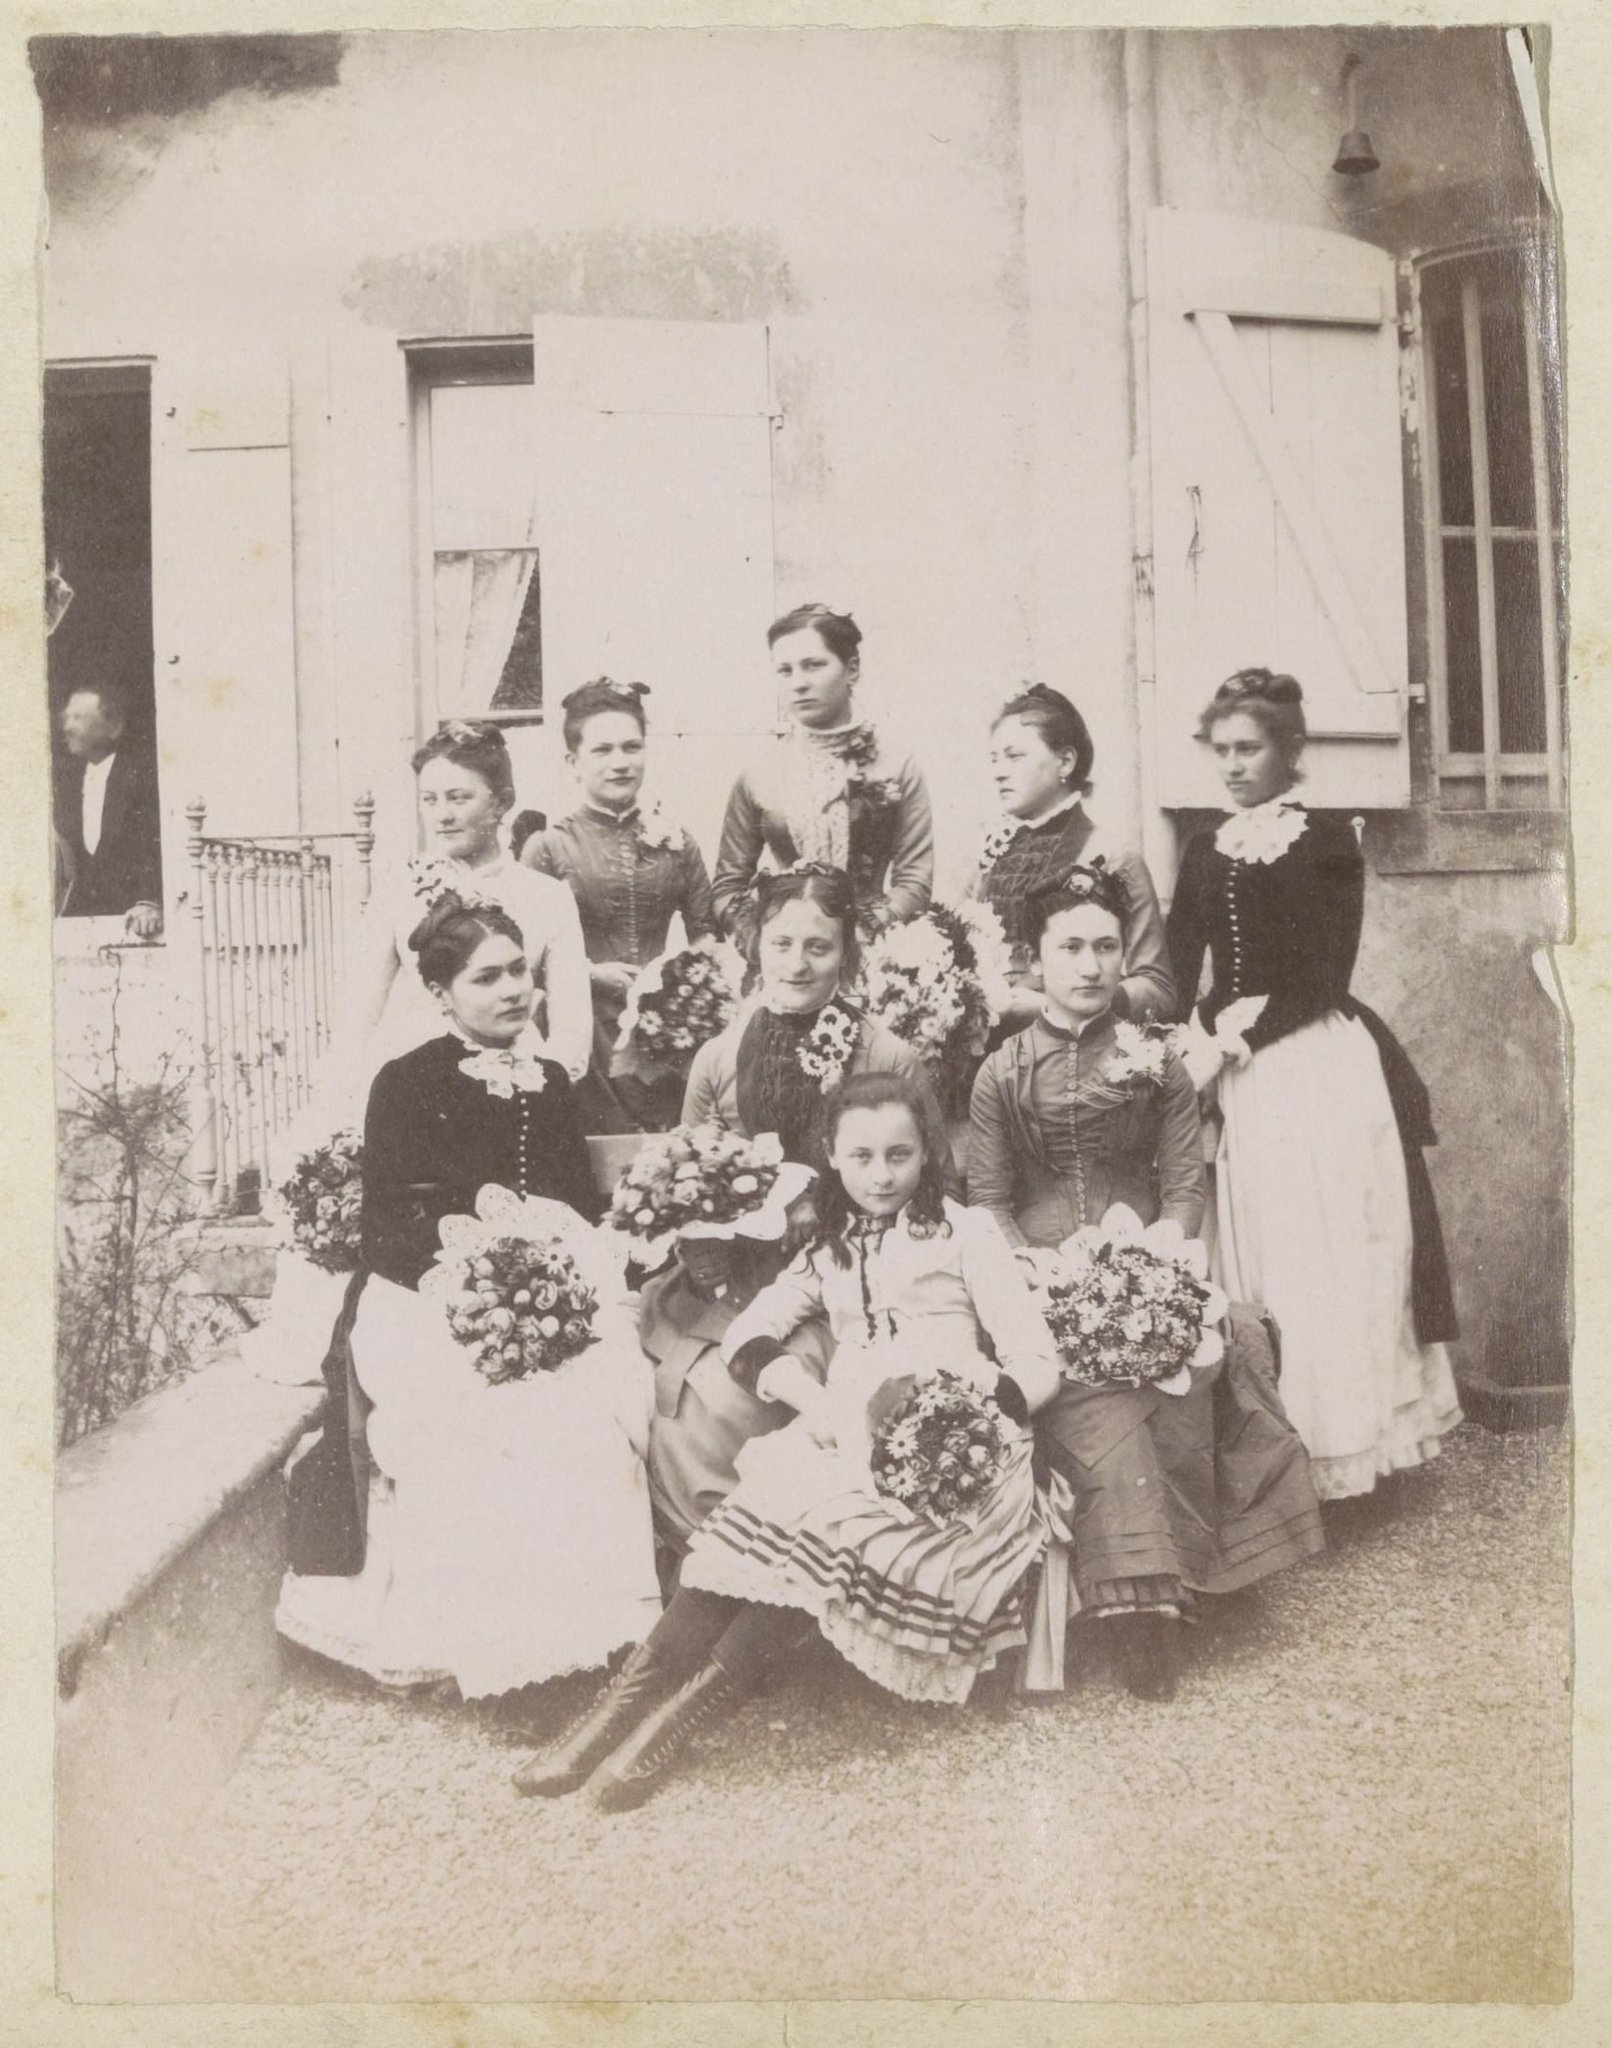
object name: photograph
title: Groepsportret van negen vrouwen met boeketten in de hand tijdens een bruiloft in Frankrijk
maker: Anonymous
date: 1808-1885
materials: photographic support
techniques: albumen print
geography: france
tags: members of bridal party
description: Onderdeel van Album van een Franse amateurfotograaf met opnames van familie, militairen, industrie, landschappen en bezienswaardigheden in Frankrijk.